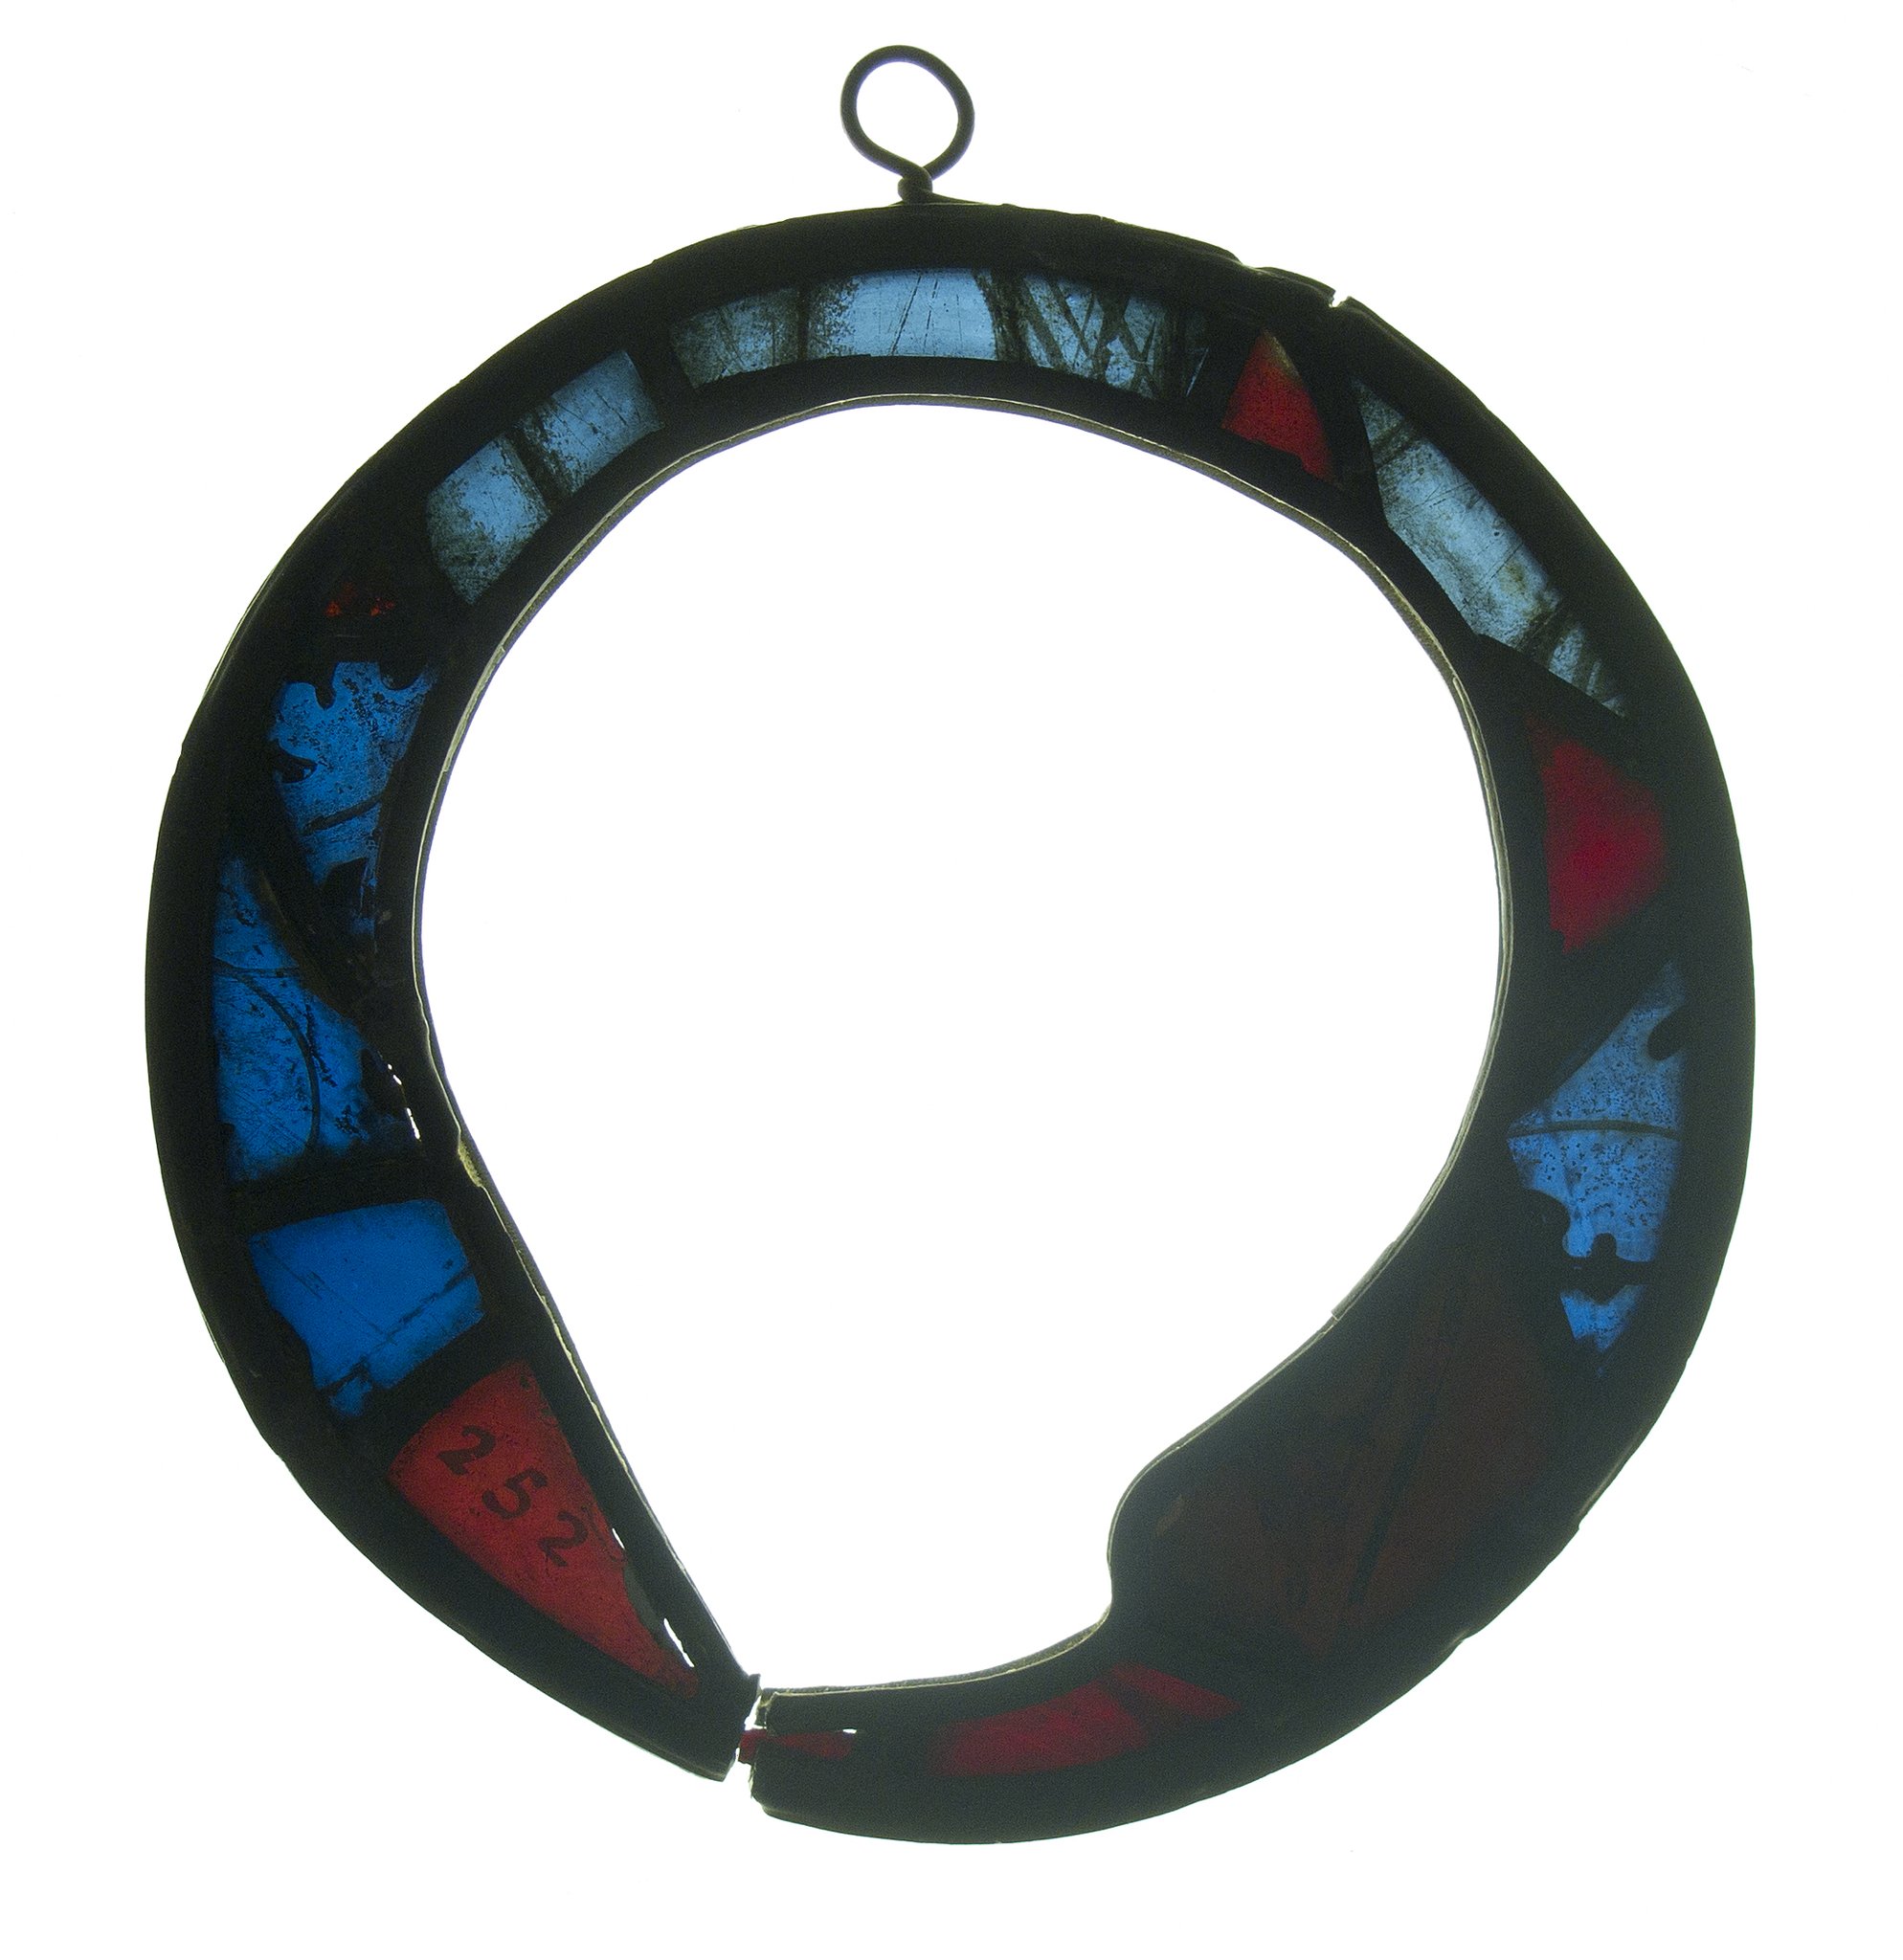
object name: fragment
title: Fragment of Border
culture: british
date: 1401-1500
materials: lead, glass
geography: england